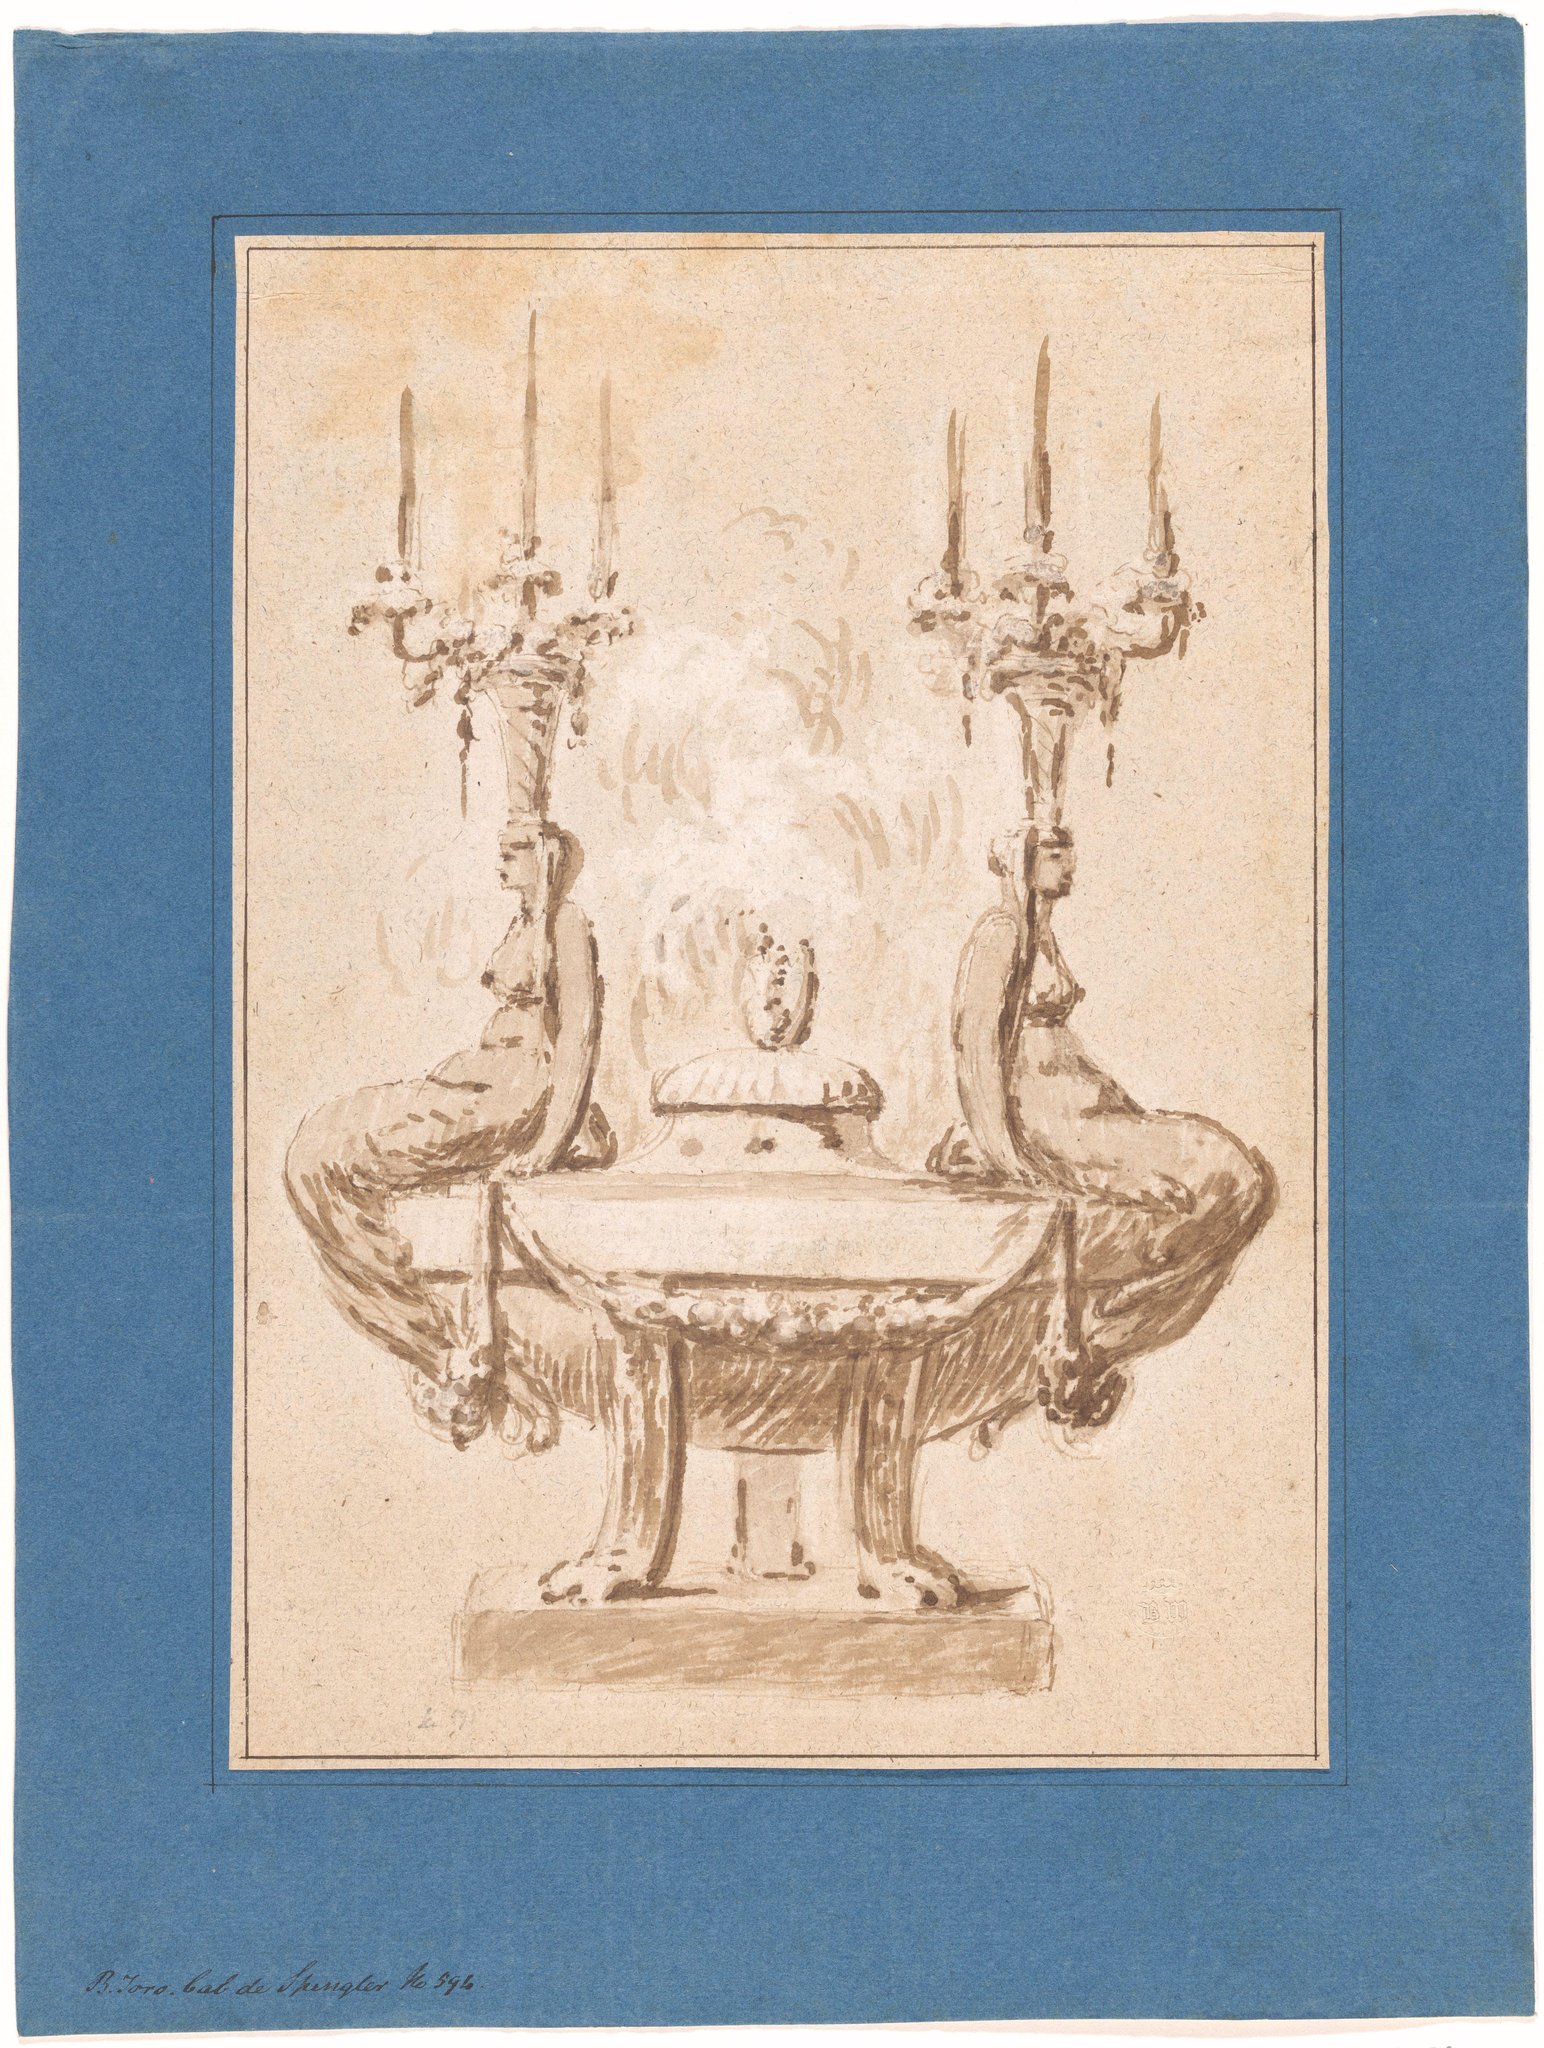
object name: design drawing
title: Ontwerp voor een kandelaber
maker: Anonymous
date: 1765-1775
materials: chalk, ink, paper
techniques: brush, pen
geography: paris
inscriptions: inscription: ‘B. Toro. Cab de Spengler. No 594 [sic]’, number: ‘596 595’, inscription: ‘No 595’, collector's mark: Lugt 420, watermark: ‘MOVENI […]?’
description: Ontwerp voor een kandelaber in de vorm van een reukvaas met twee zittende vrouwen die elk een driearmige kandelaber op het hoofd dragen.